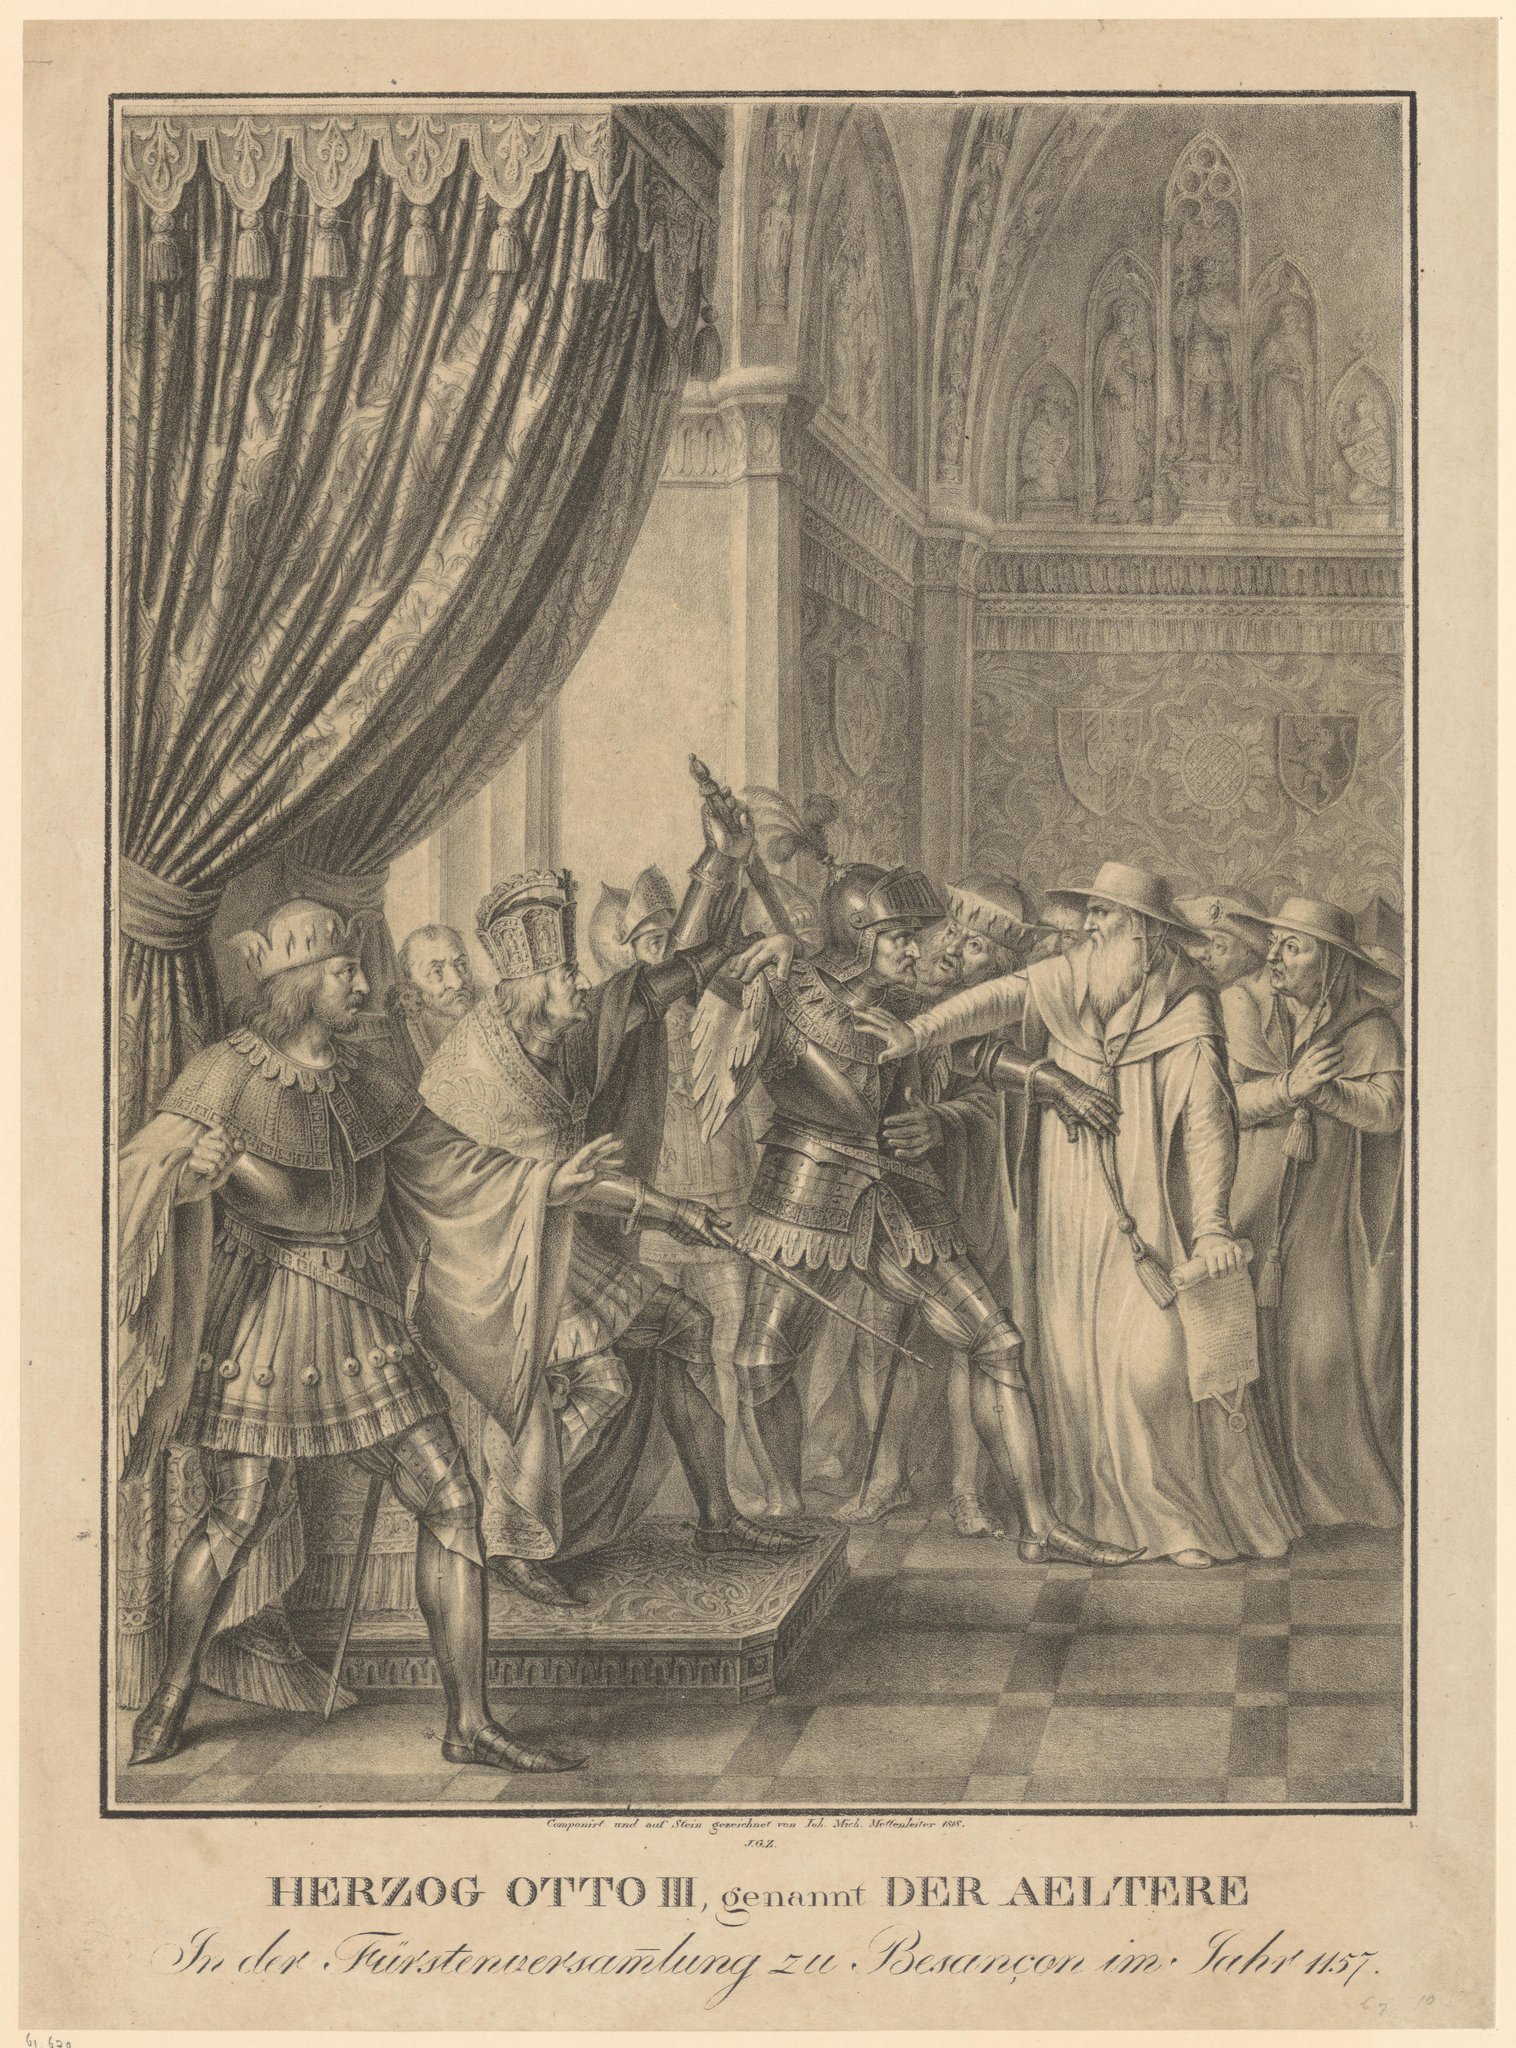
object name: print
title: Hertog Otto III tijdens de prinselijke vergadering te Besançon in het jaar 1157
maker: johann michael mettenleiter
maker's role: print maker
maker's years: 1765-1853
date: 1818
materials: paper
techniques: lithograph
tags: armour, cardinal, throne, audition; ruler giving audience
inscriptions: collector's mark: Lugt 2228, mark